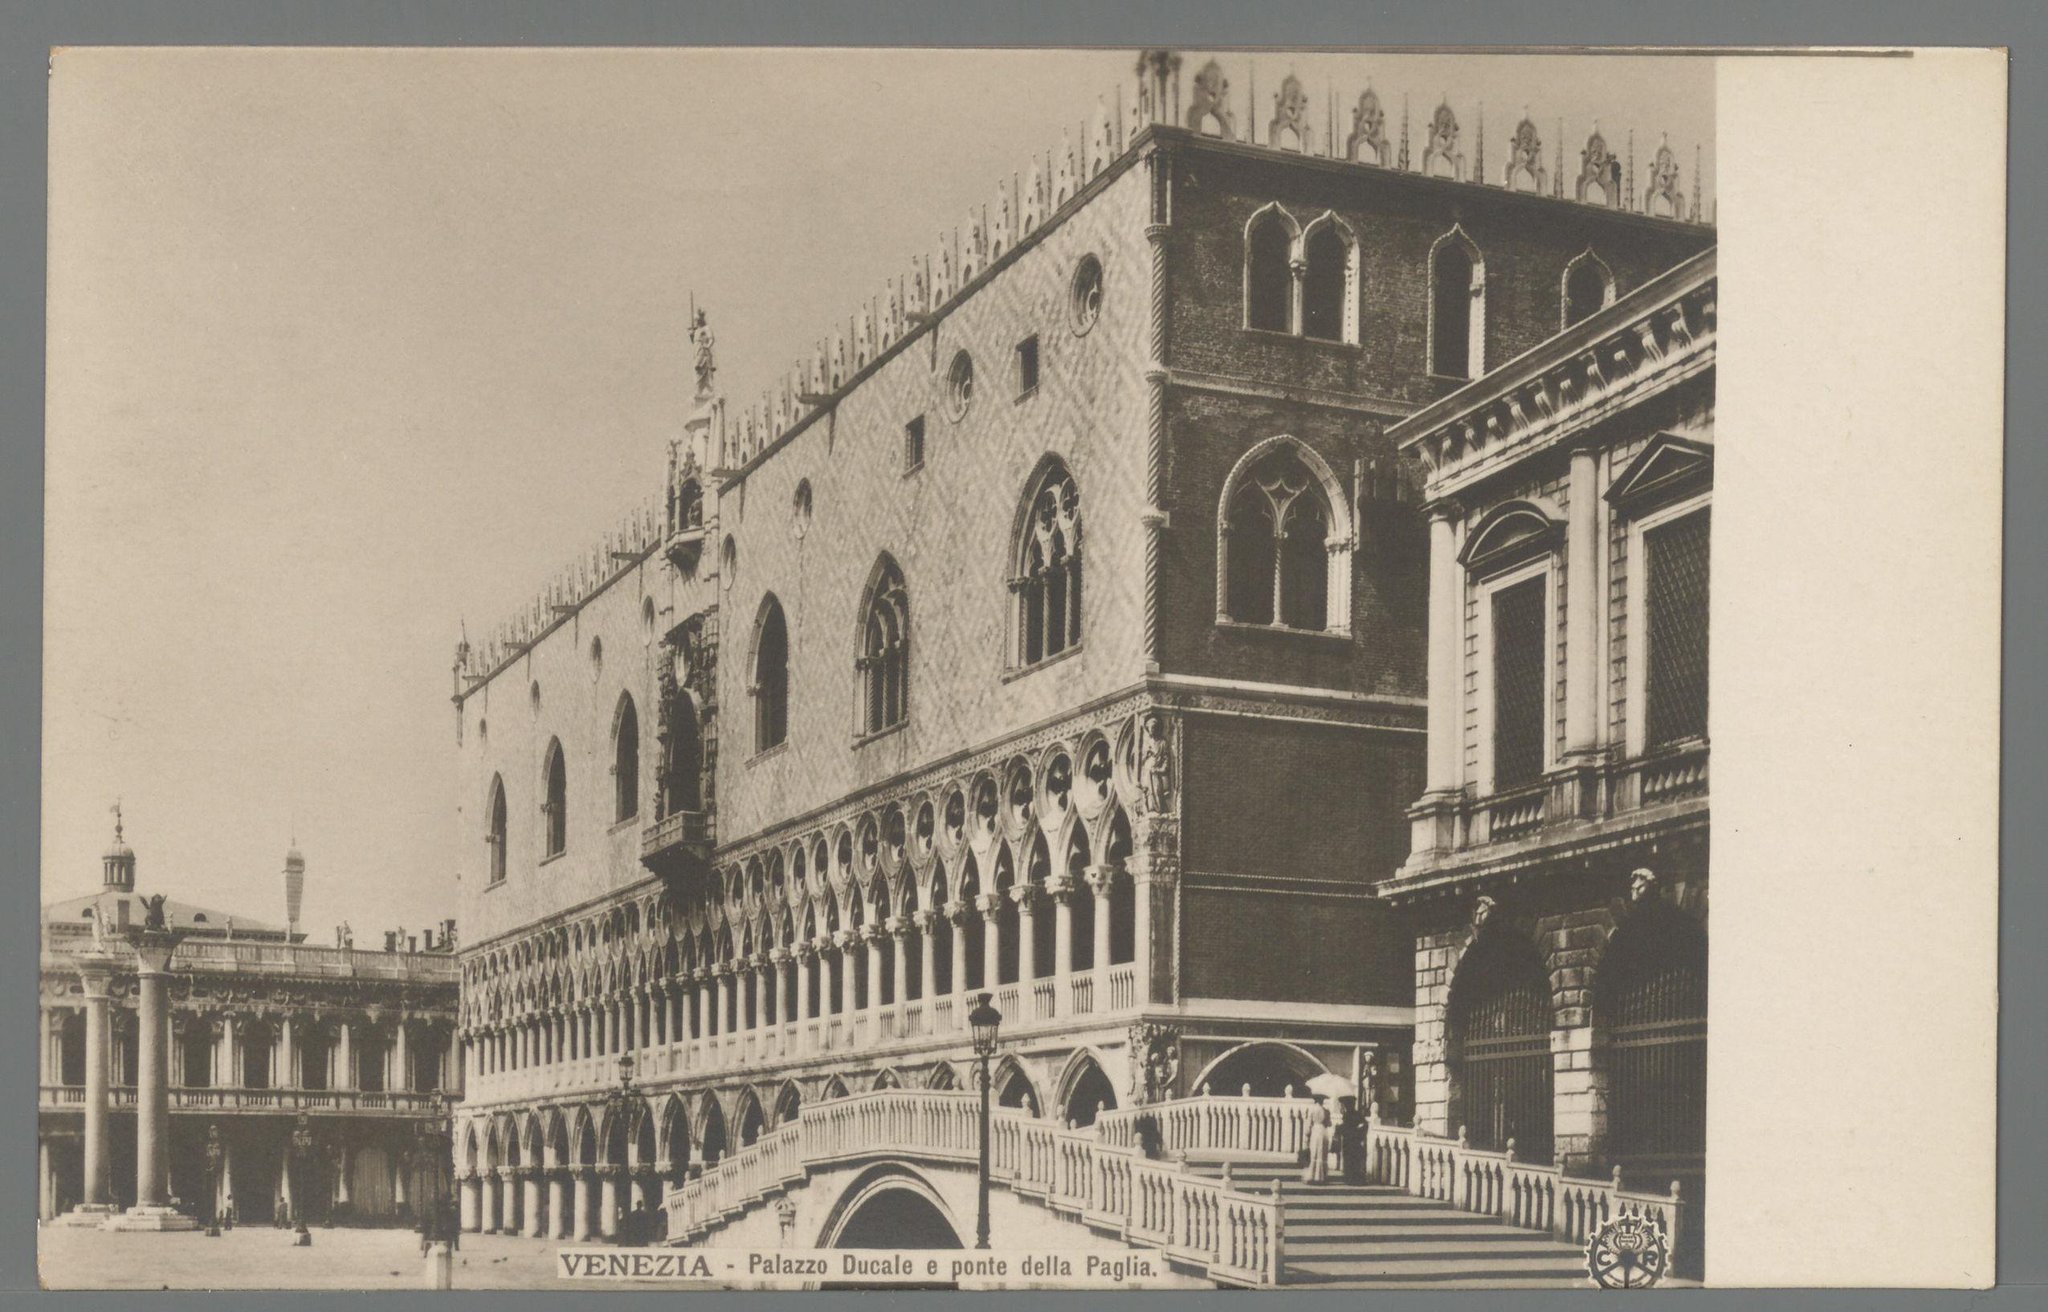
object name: photograph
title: Venezia. Palazzo Ducale e ponte della Paglia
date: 1900-1906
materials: photographic support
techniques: photography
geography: venice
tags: palace, bridge in city across river, canal, etc., square, place, circus, etc. (+ city(-scape) with figures, staffage)